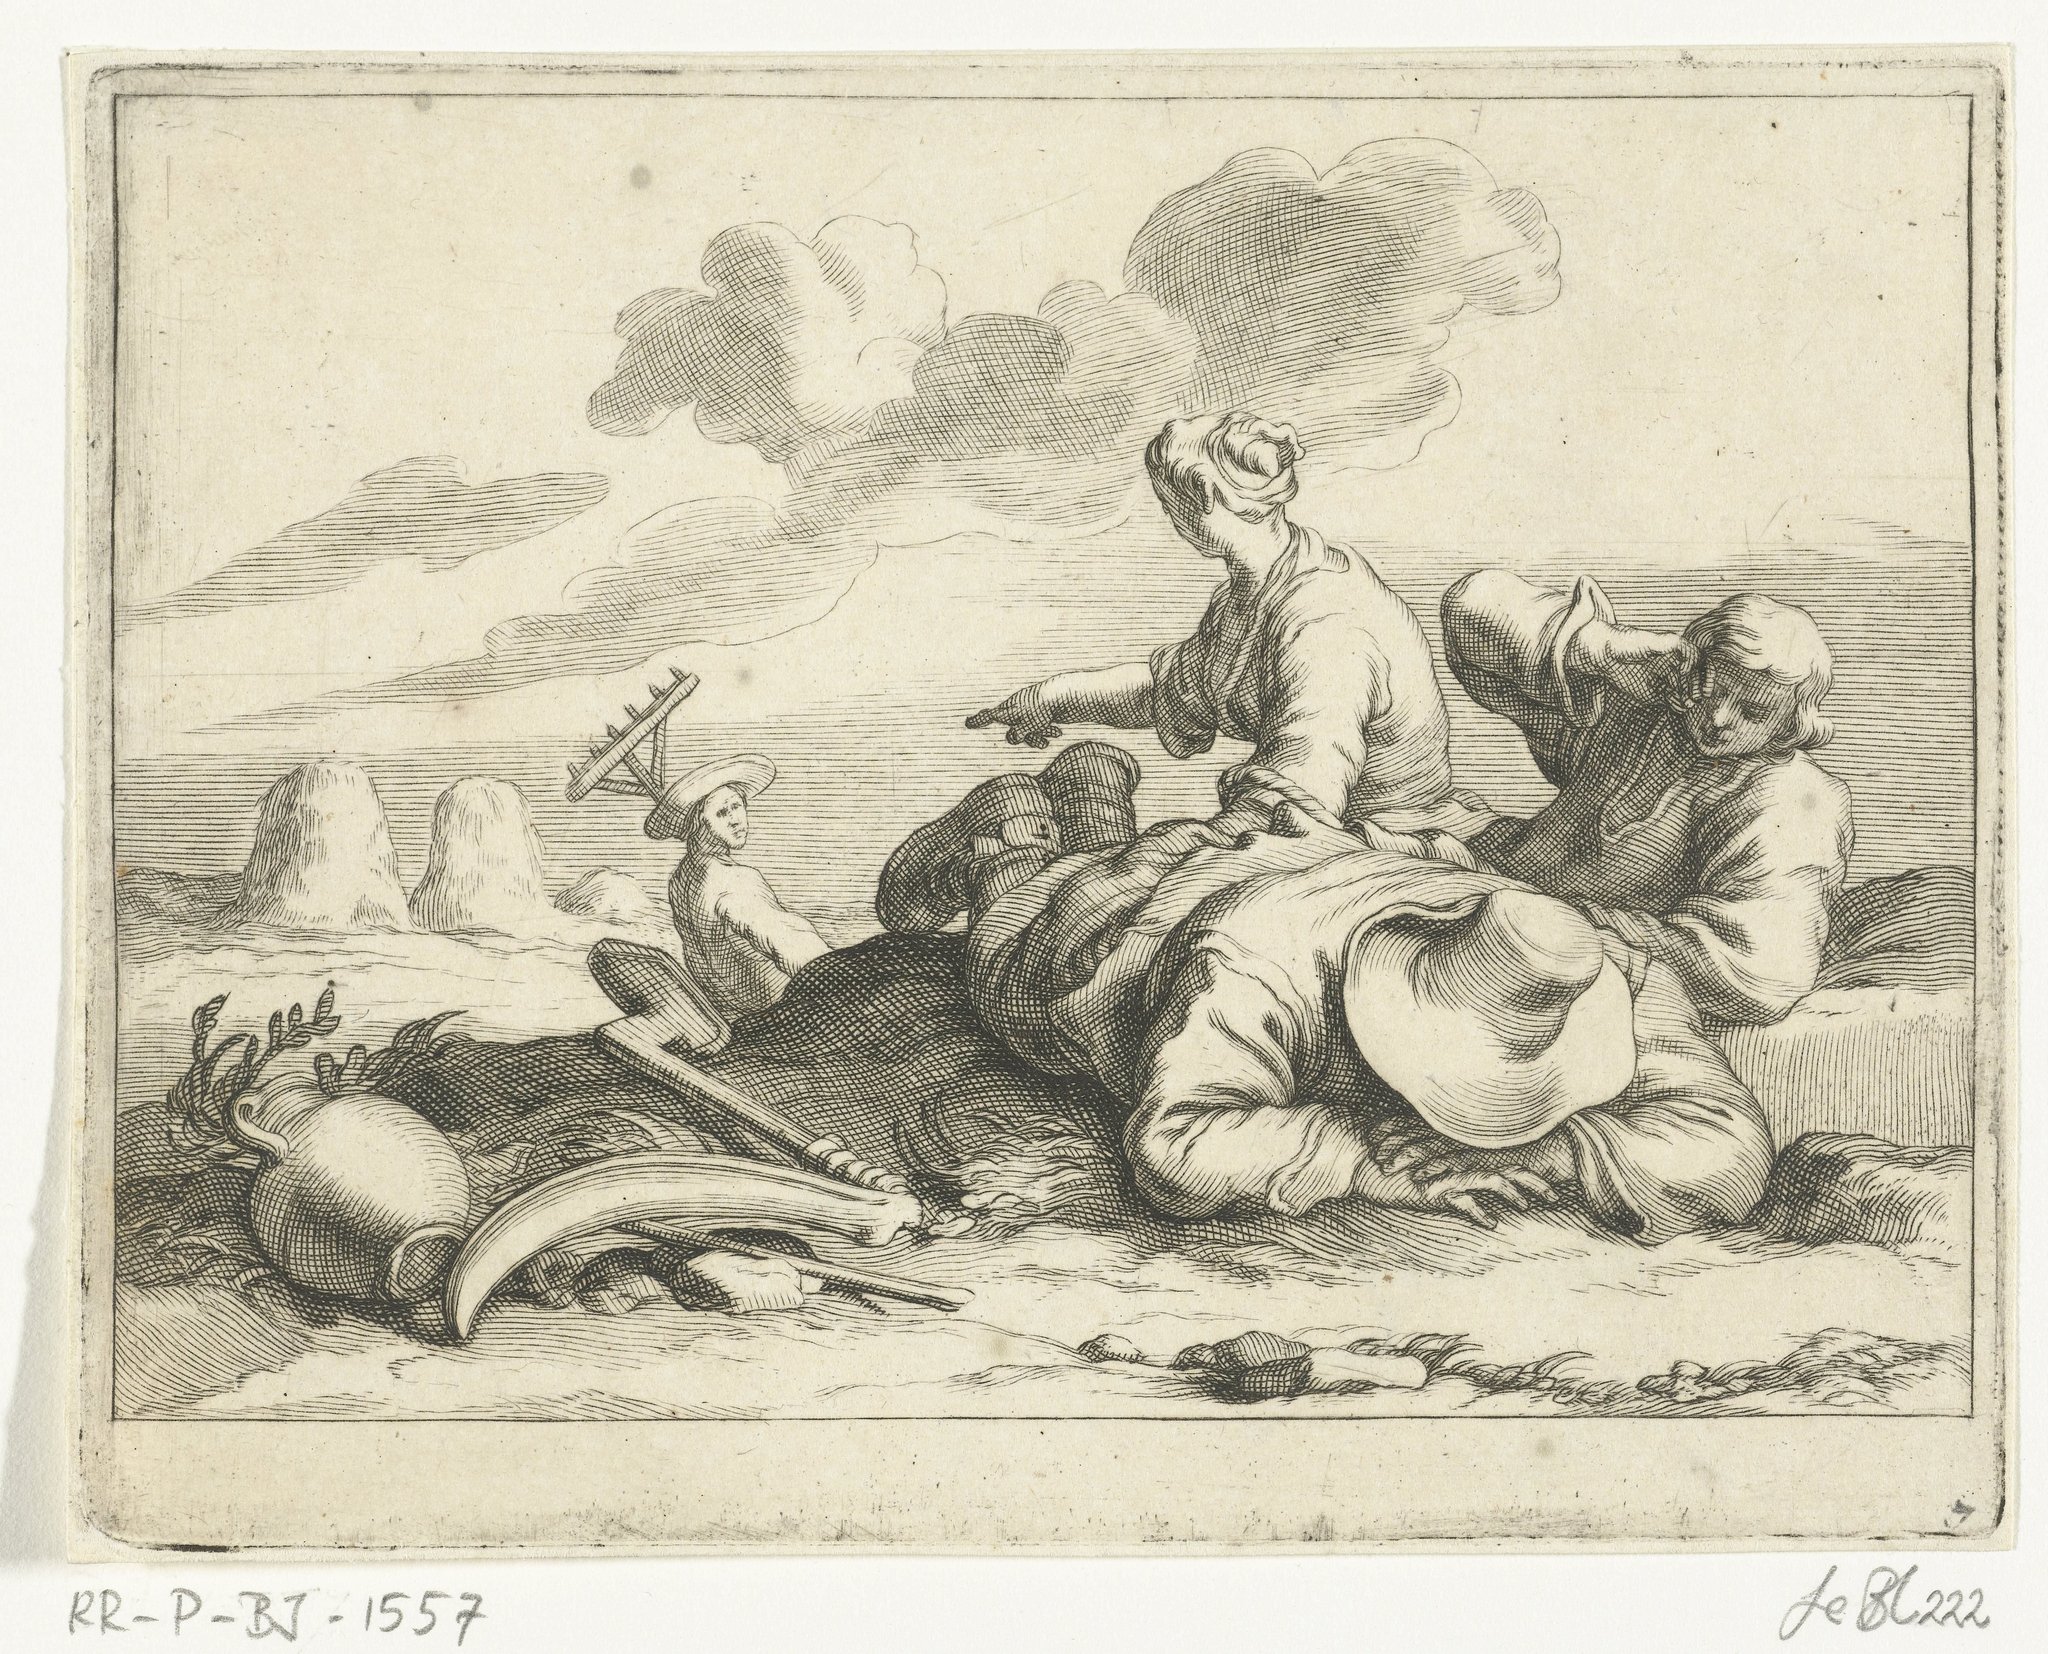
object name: print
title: De maand juli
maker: frederick bloemaert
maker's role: print maker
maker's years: 1614-1669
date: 1635-1670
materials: paper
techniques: engraving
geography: utrecht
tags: july and its 'labours', rest during harvest (eating, dancing, making love, etc.)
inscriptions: collector's mark: Lugt 240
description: Boeren pauzeren tijdens het oogsten. Links een kruik en een sikkel, op de achtergrond hooibergen.